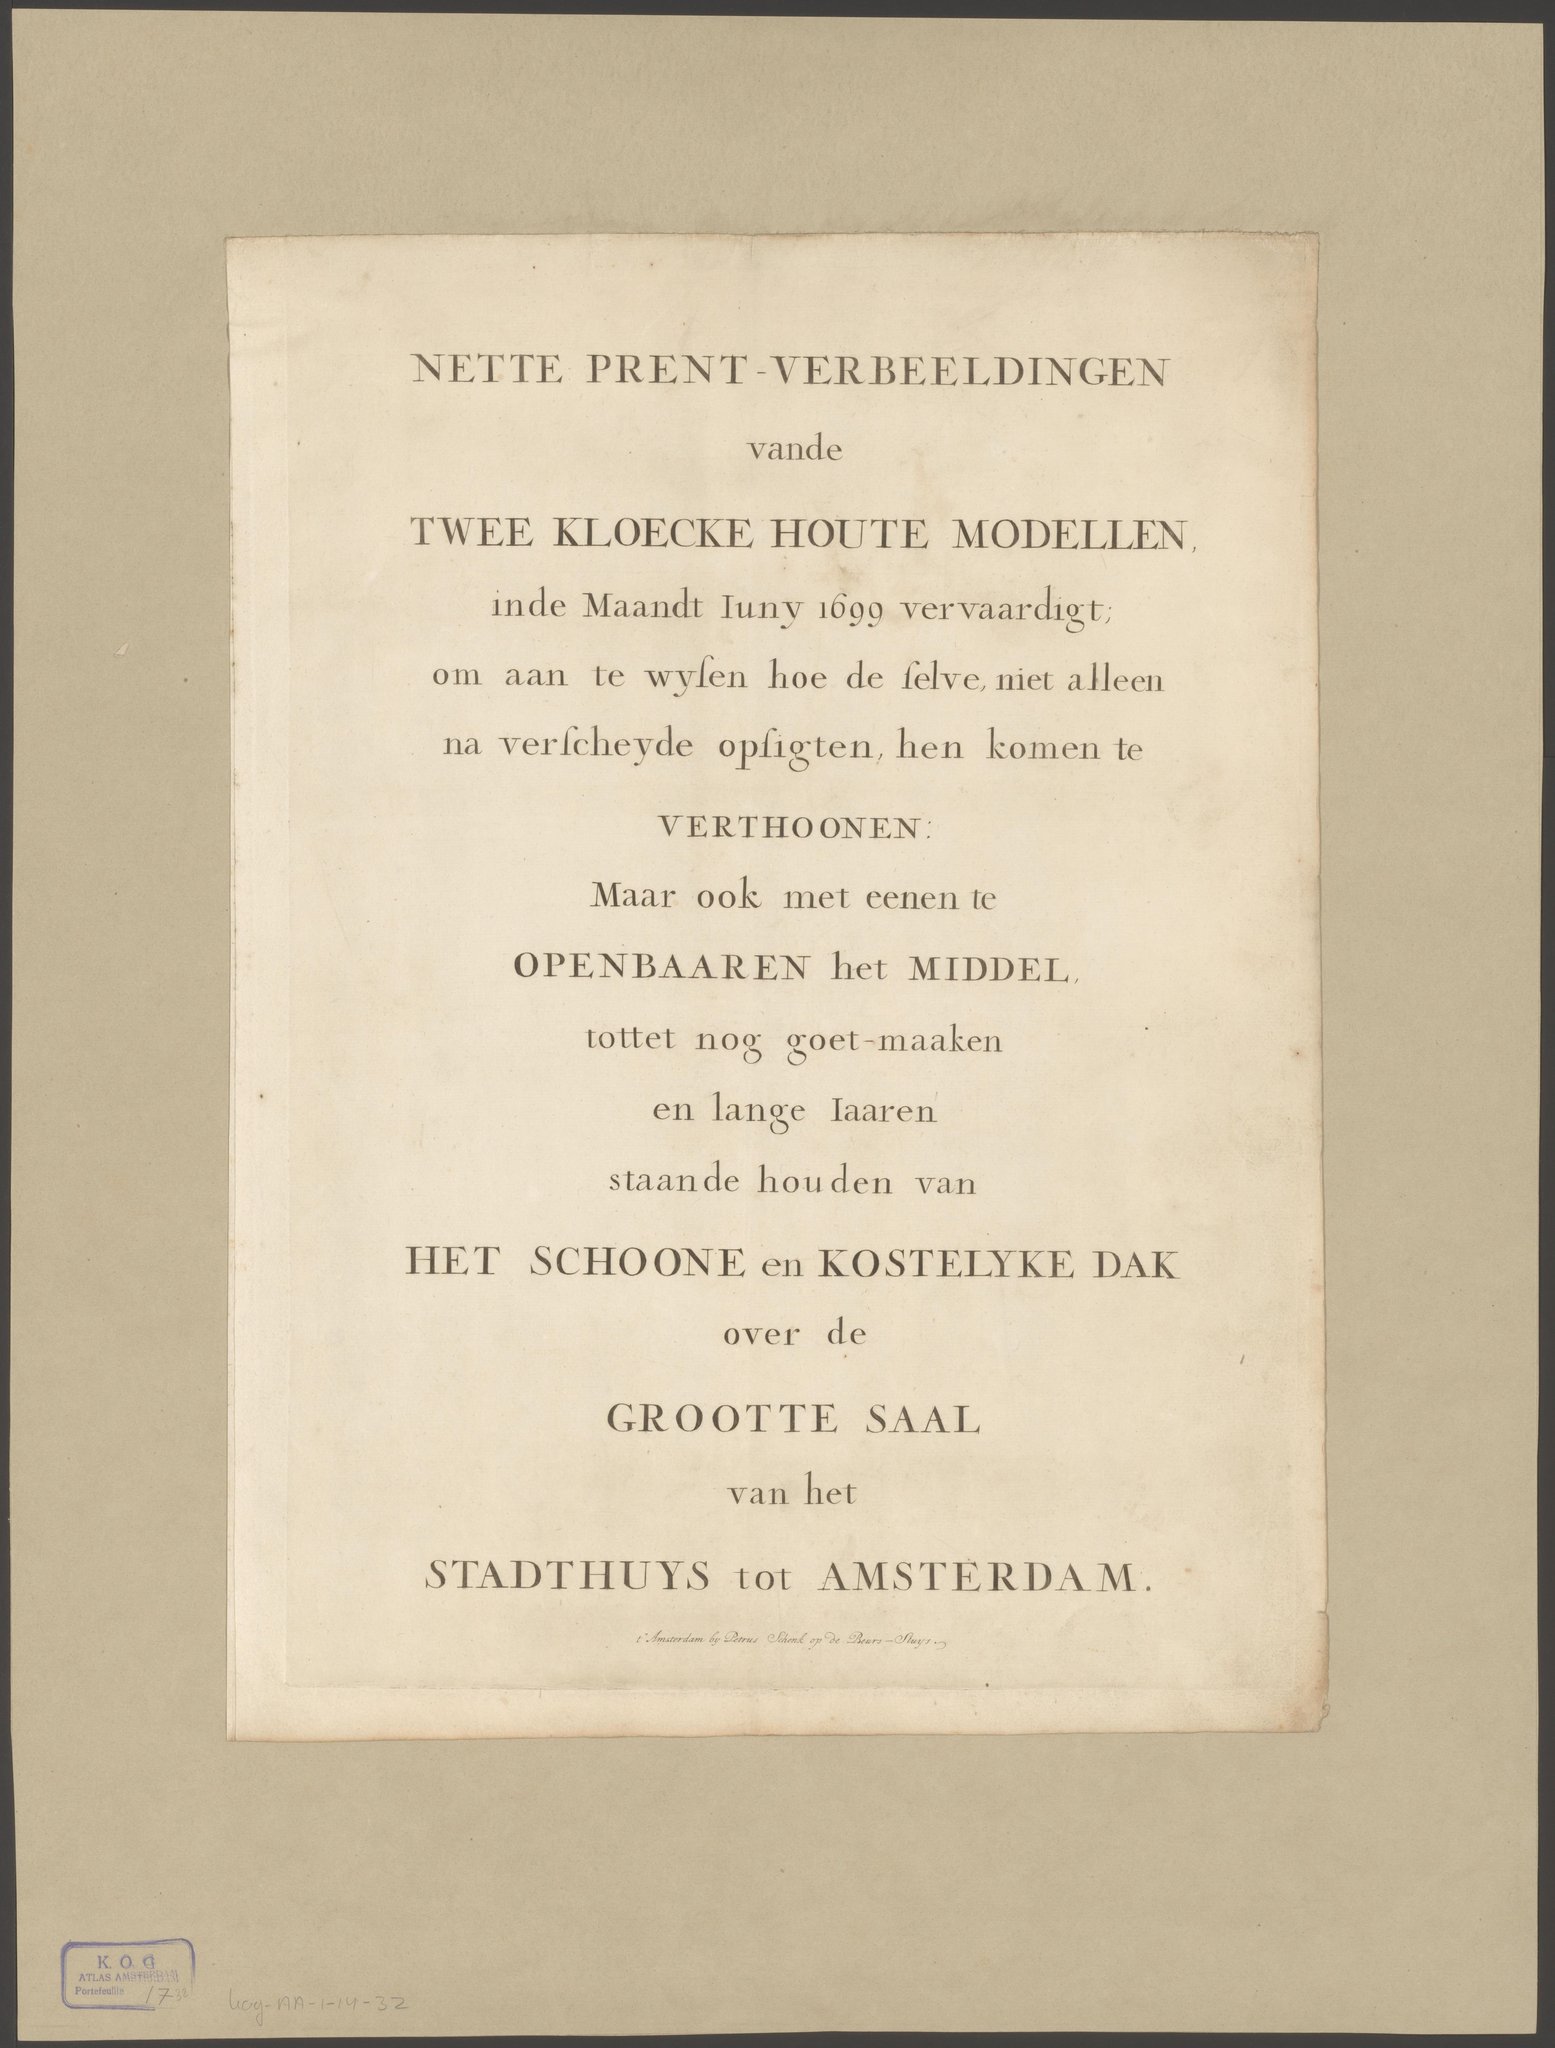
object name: print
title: Titelpagina voor: Nette Prent-Verbeeldingen vande Twee Kloecke Houte Modellen (...), [1660-1695]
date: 1660-1695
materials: paper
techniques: engraving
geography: amsterdam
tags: townhall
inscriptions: collector's mark: ‘17 32’ Lugt 1641b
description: Titelpagina voor: Nette Prent-Verbeeldingen vande Twee Kloecke Houte Modellen (...). Amsterdam: Pieter Schenk I, [1660-1695].